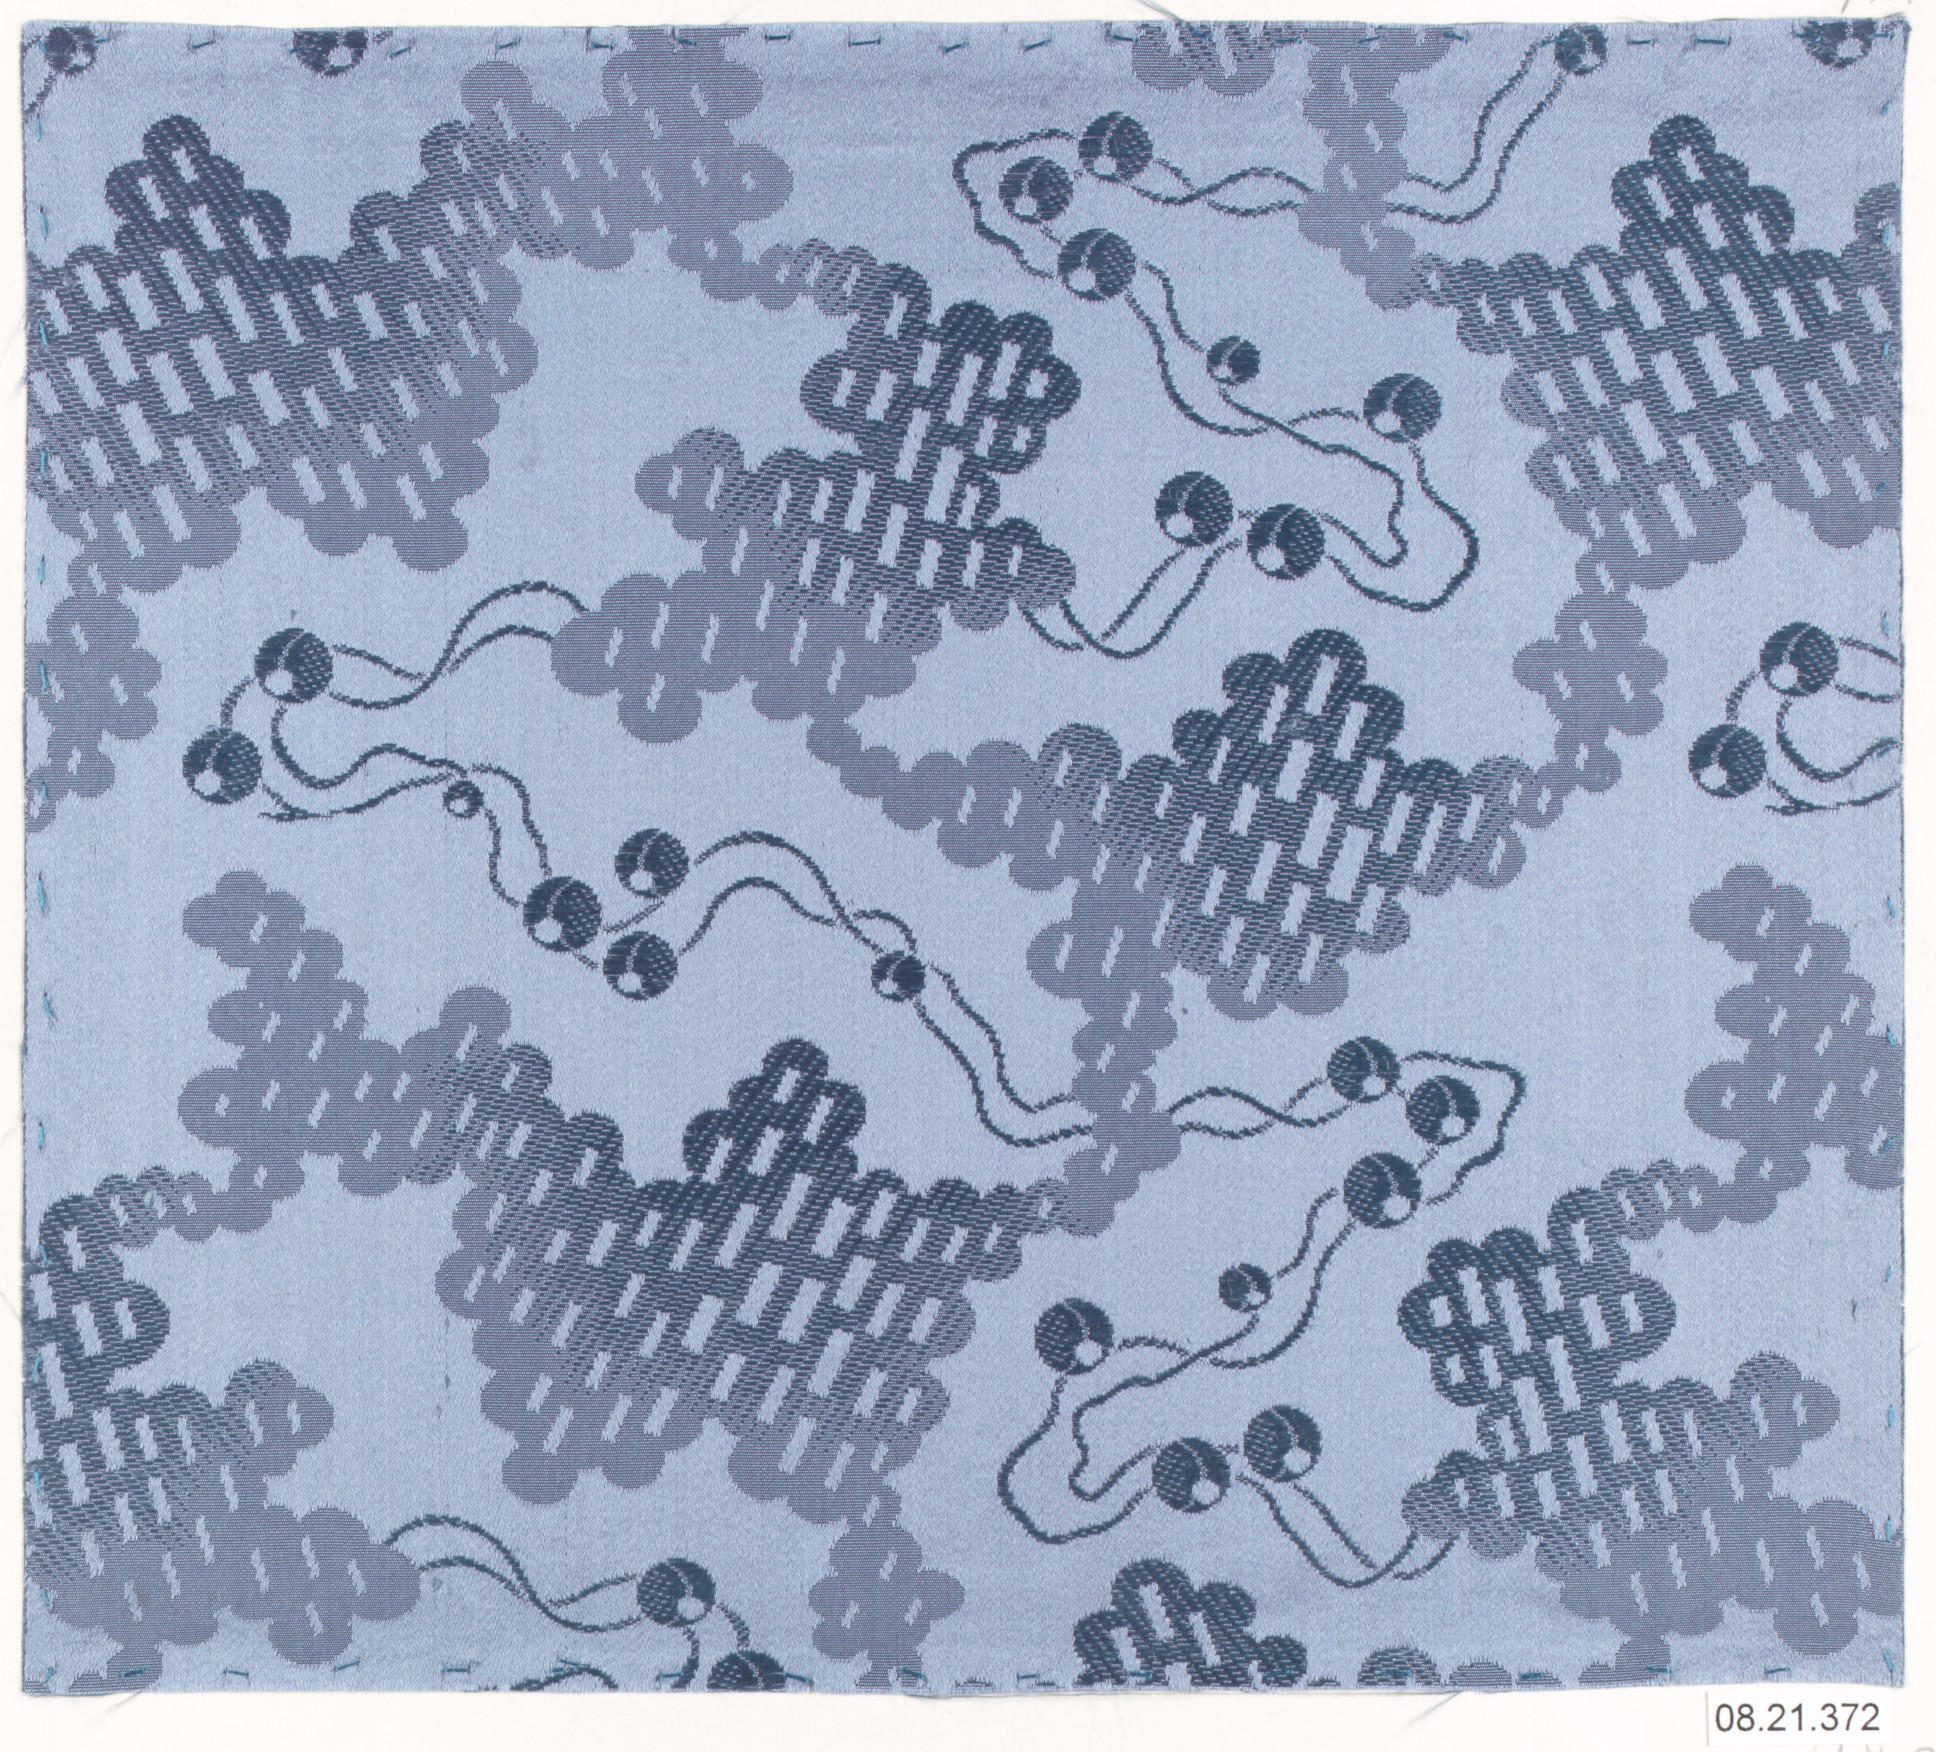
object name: textile sample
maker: Anonymous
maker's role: designer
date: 1900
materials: silk